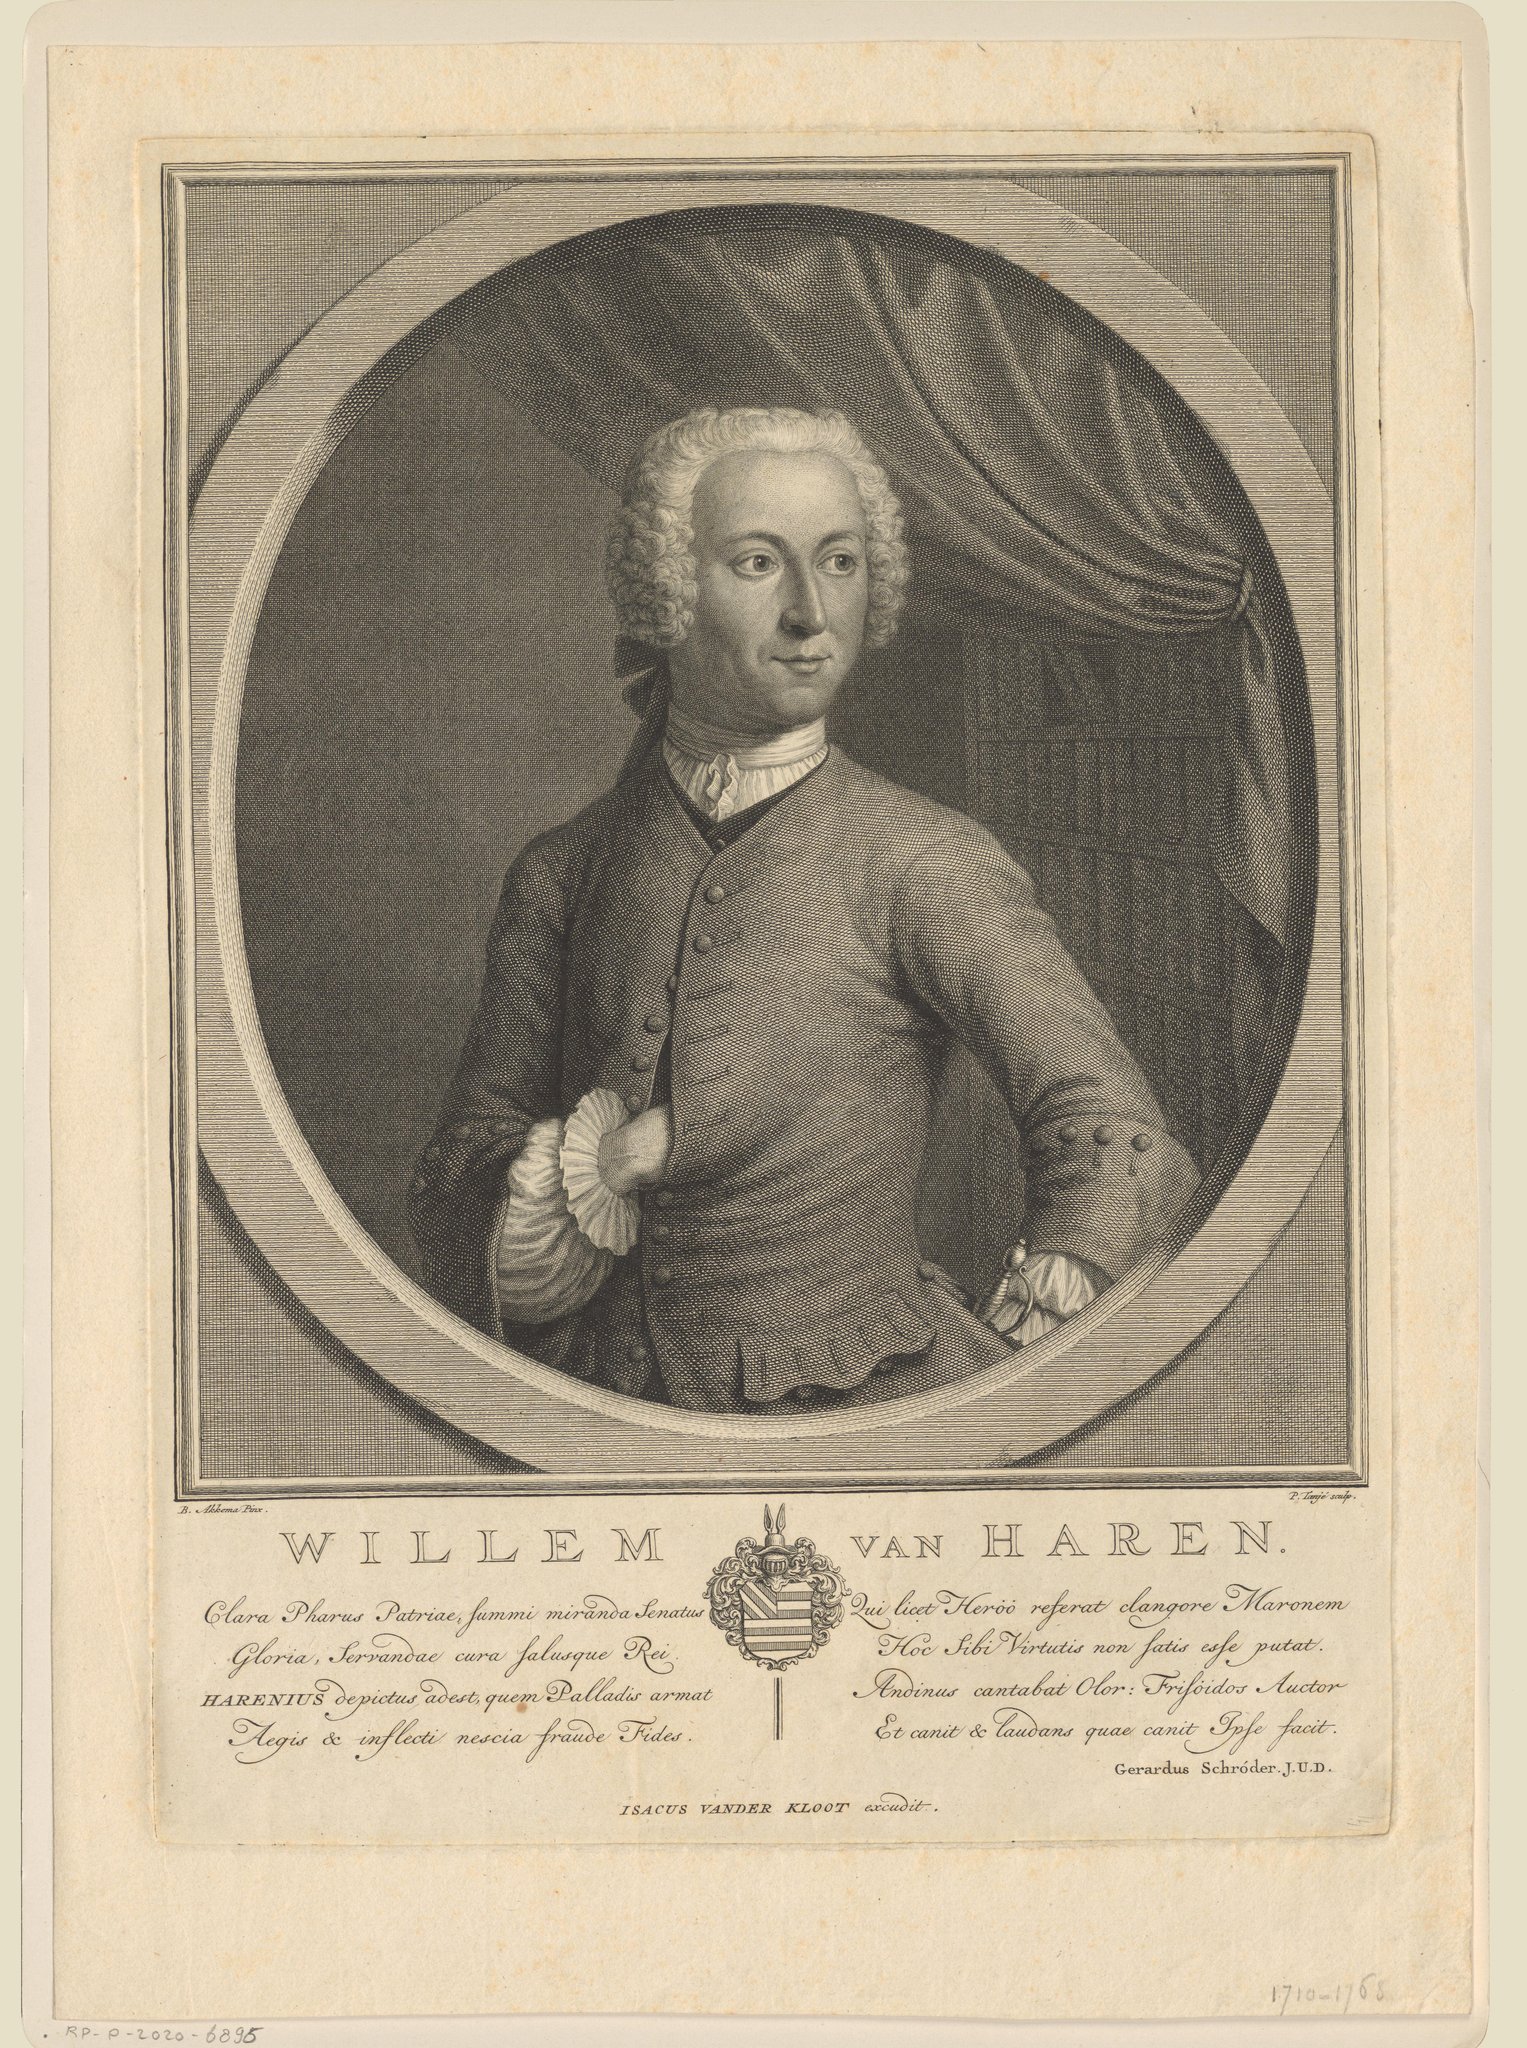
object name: print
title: Portret van Willem van Haren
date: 1727-1741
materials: paper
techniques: engraving, etching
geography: the hague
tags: bookshelves, historical persons, writer, poet, author, armorial bearing, heraldry